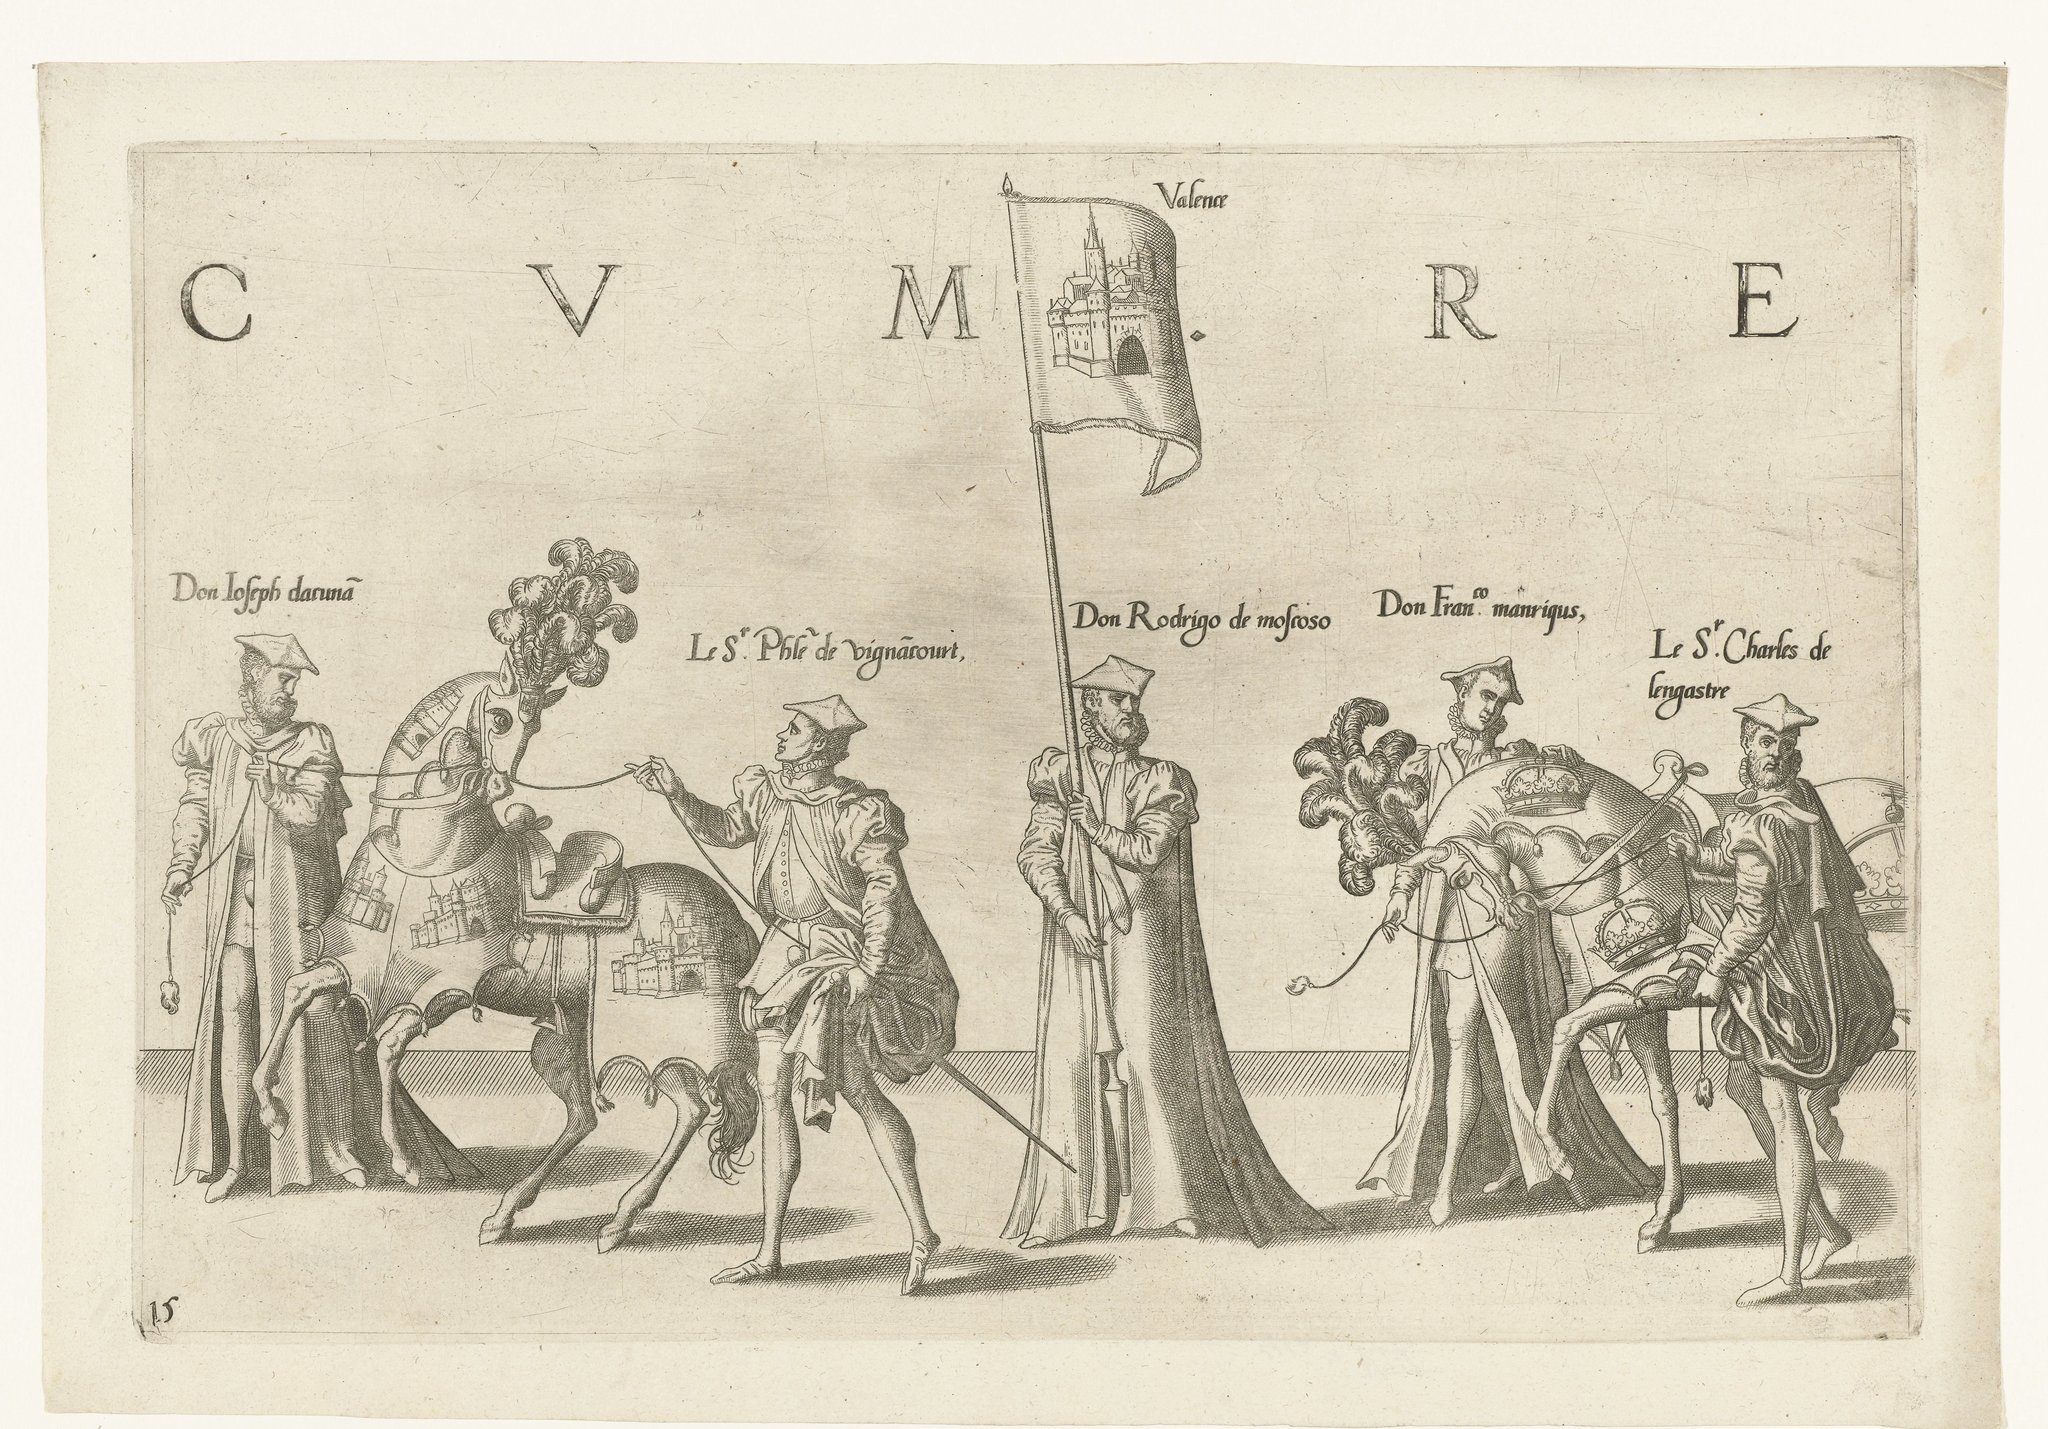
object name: print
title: Deel van de optocht, nr. 15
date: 1559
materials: paper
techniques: engraving, etching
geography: southern netherlands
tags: ghent, charles v (holy roman emperor and king of spain), cortege, funeral procession, brussels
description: Vijf deelnemers aan de optocht, paarden en het vaandel met het wapen van Valencia. Onderdeel van de prentreeks van de Begrafenisoptocht van keizer Karel V op 29 december 1558 te Brussel.